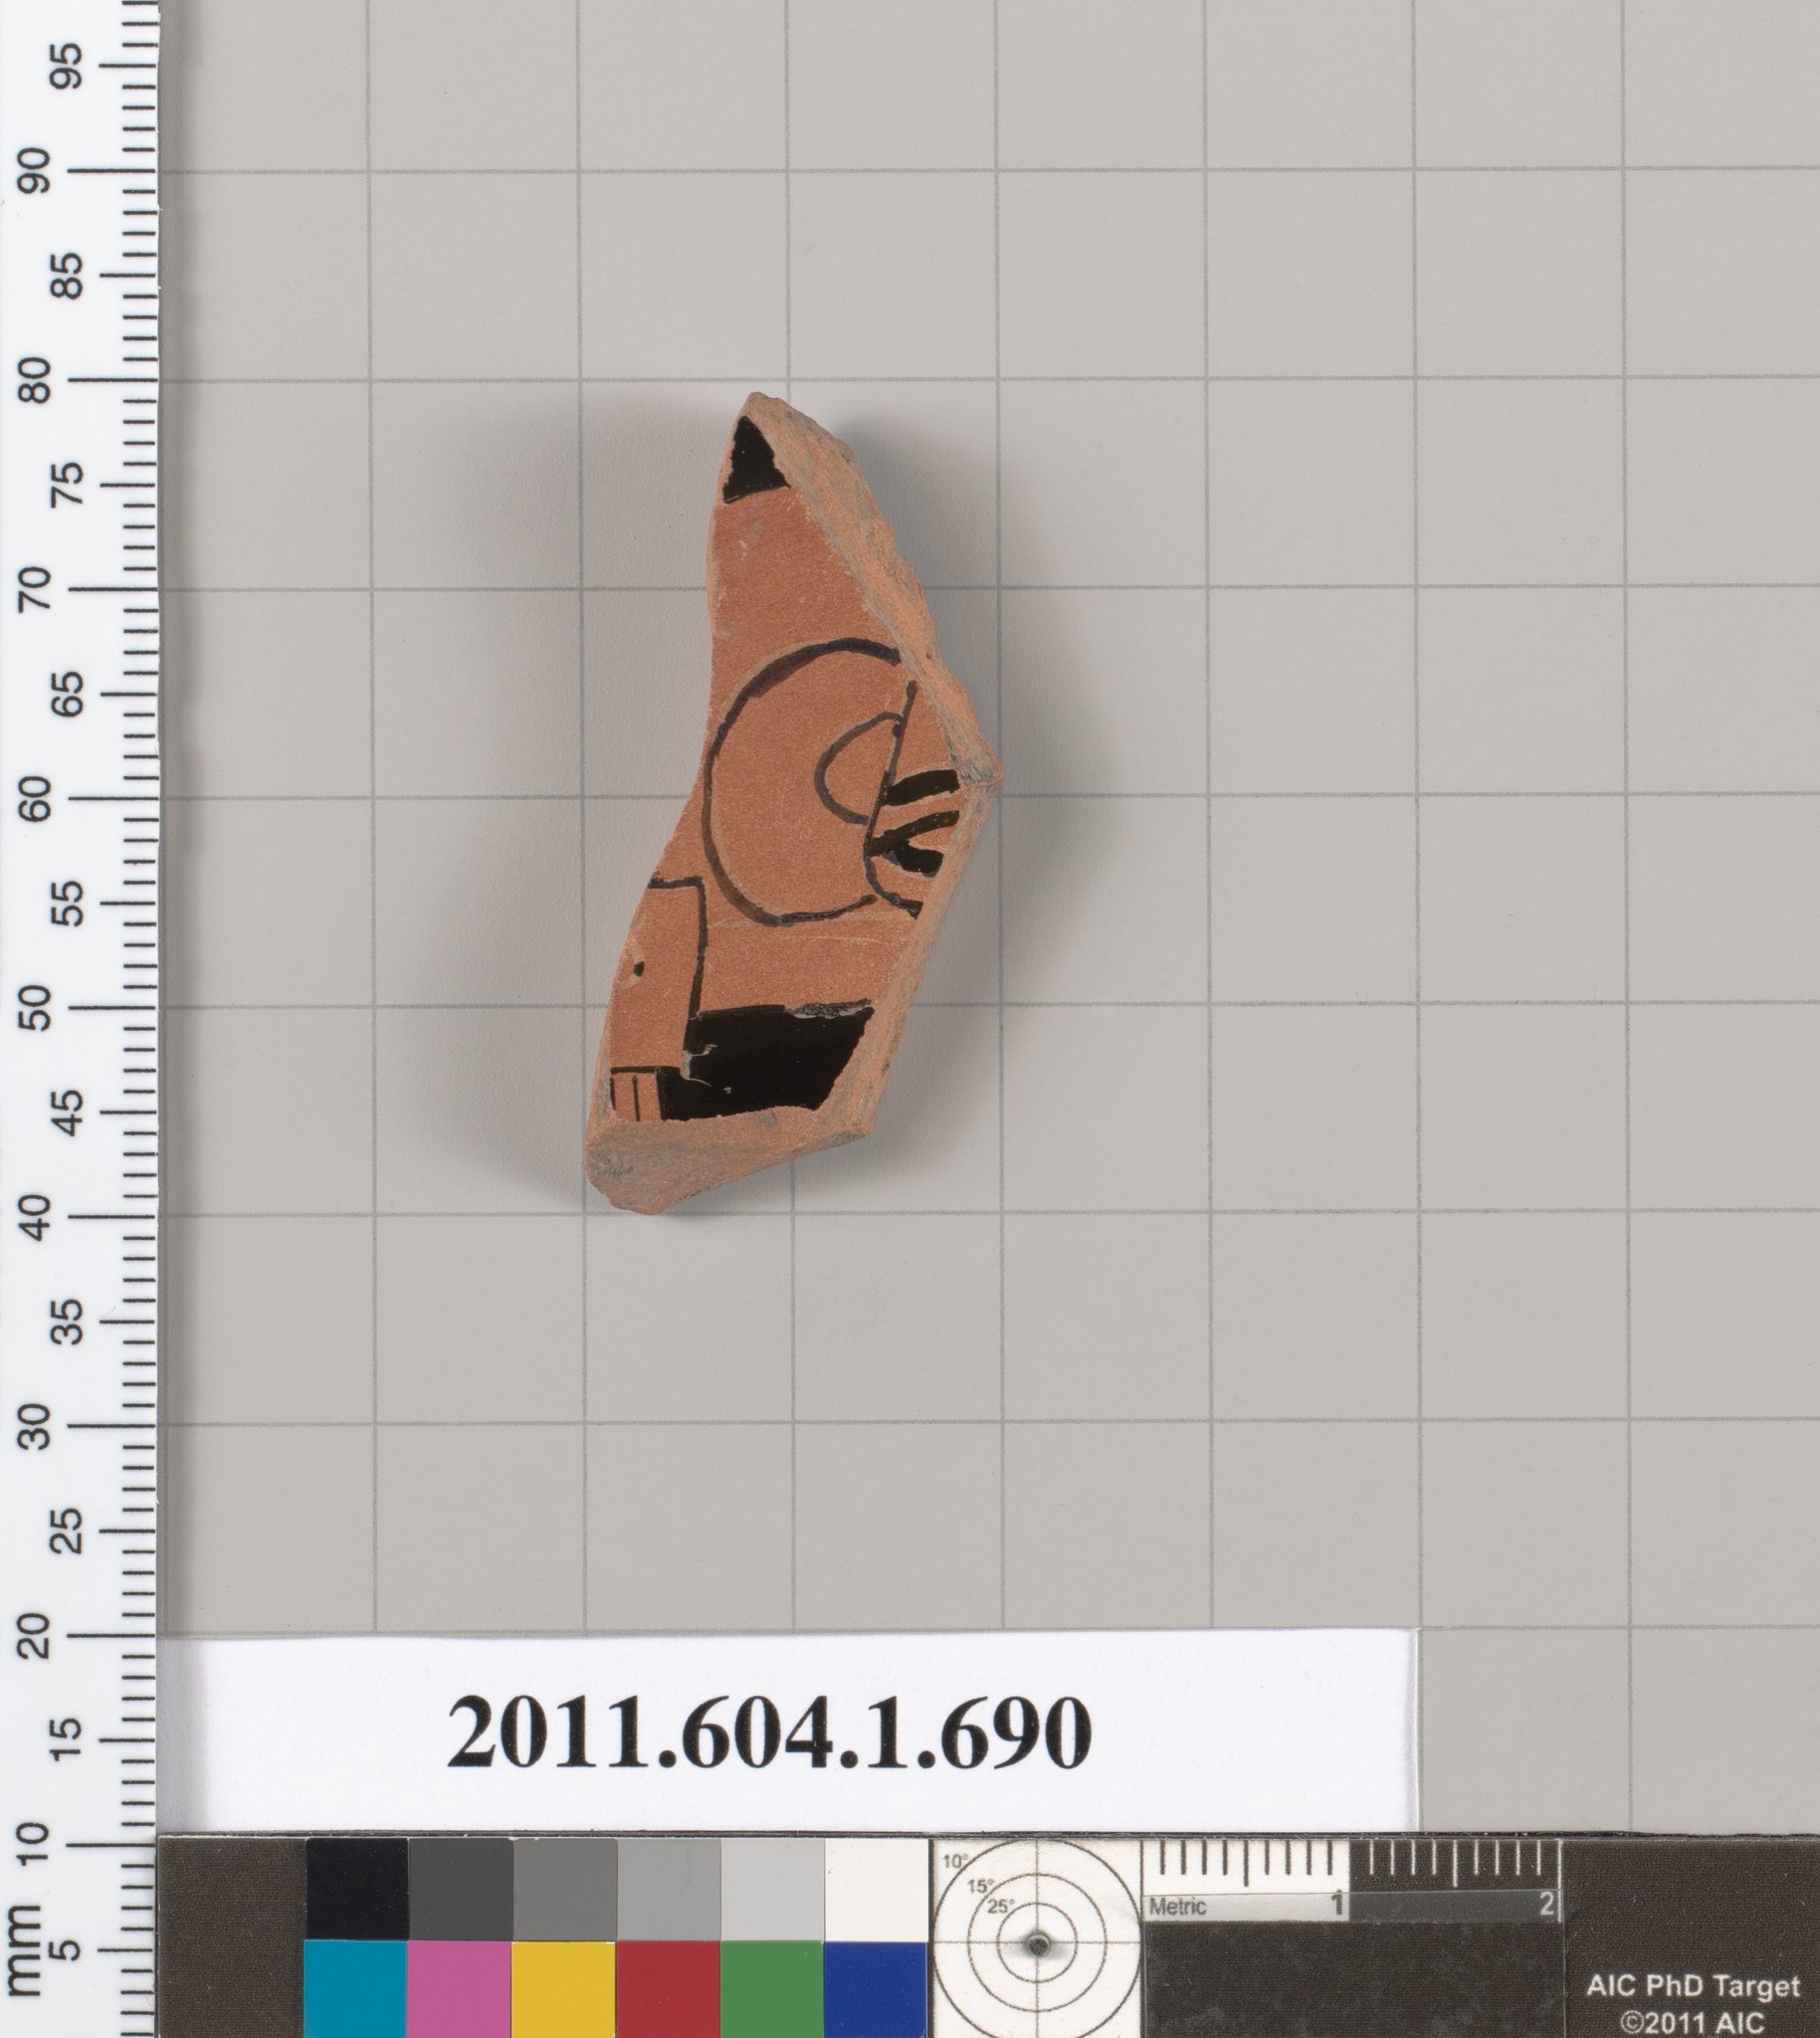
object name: kylix fragment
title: Terracotta fragment of a kylix (drinking cup)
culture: greek, attic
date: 490-480 BCE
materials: terracotta